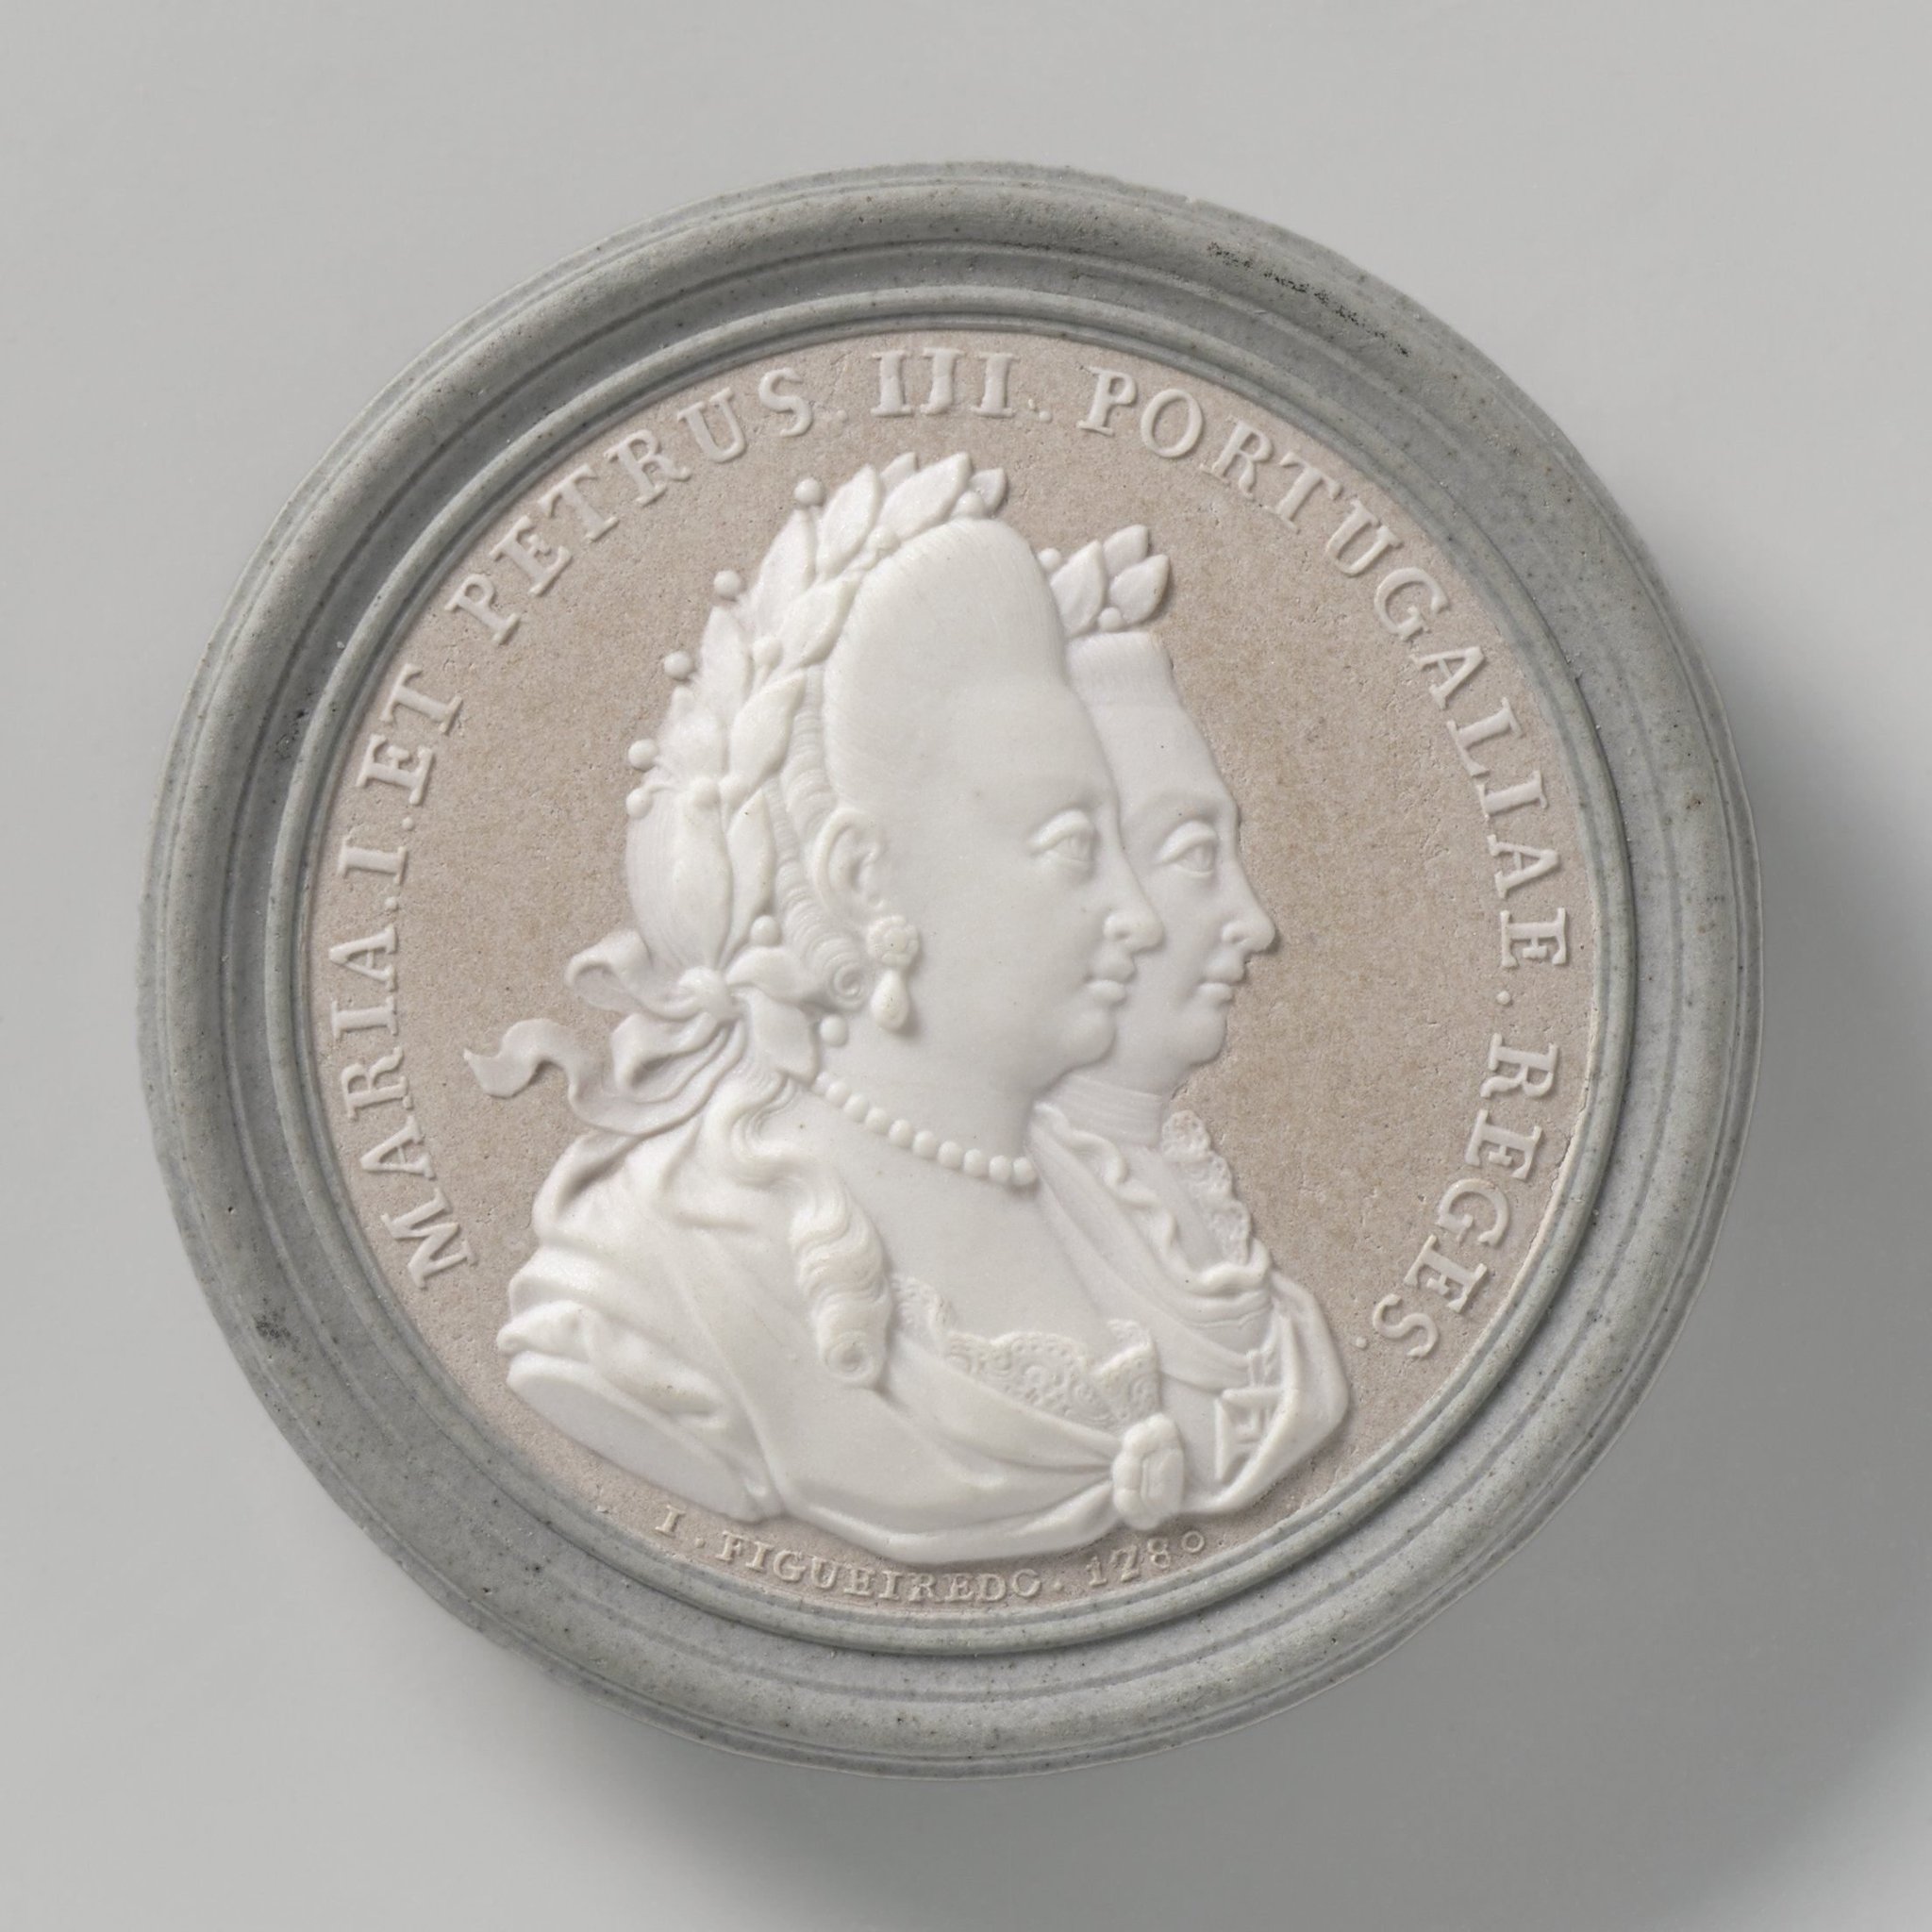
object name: locket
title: Medallion with the portraits of Maria I and Pedro III, queen and king of Portugal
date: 1780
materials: glaze, paint, porcelain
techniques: firing, forming, relief, vitrification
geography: lisbon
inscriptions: inscription: ‘I.FIGUEIREDO.1780.’, inscription: ‘MARIA.I ET PETRUS.III PORTUGALIAE. REGES’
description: Portretmedaillon, voorstellend Pedro III en Maria I, koning en koningin van Portugal. Bisquit-porselein Lissabon, gedateerd 1780. Het model door Joao Figueiredo.